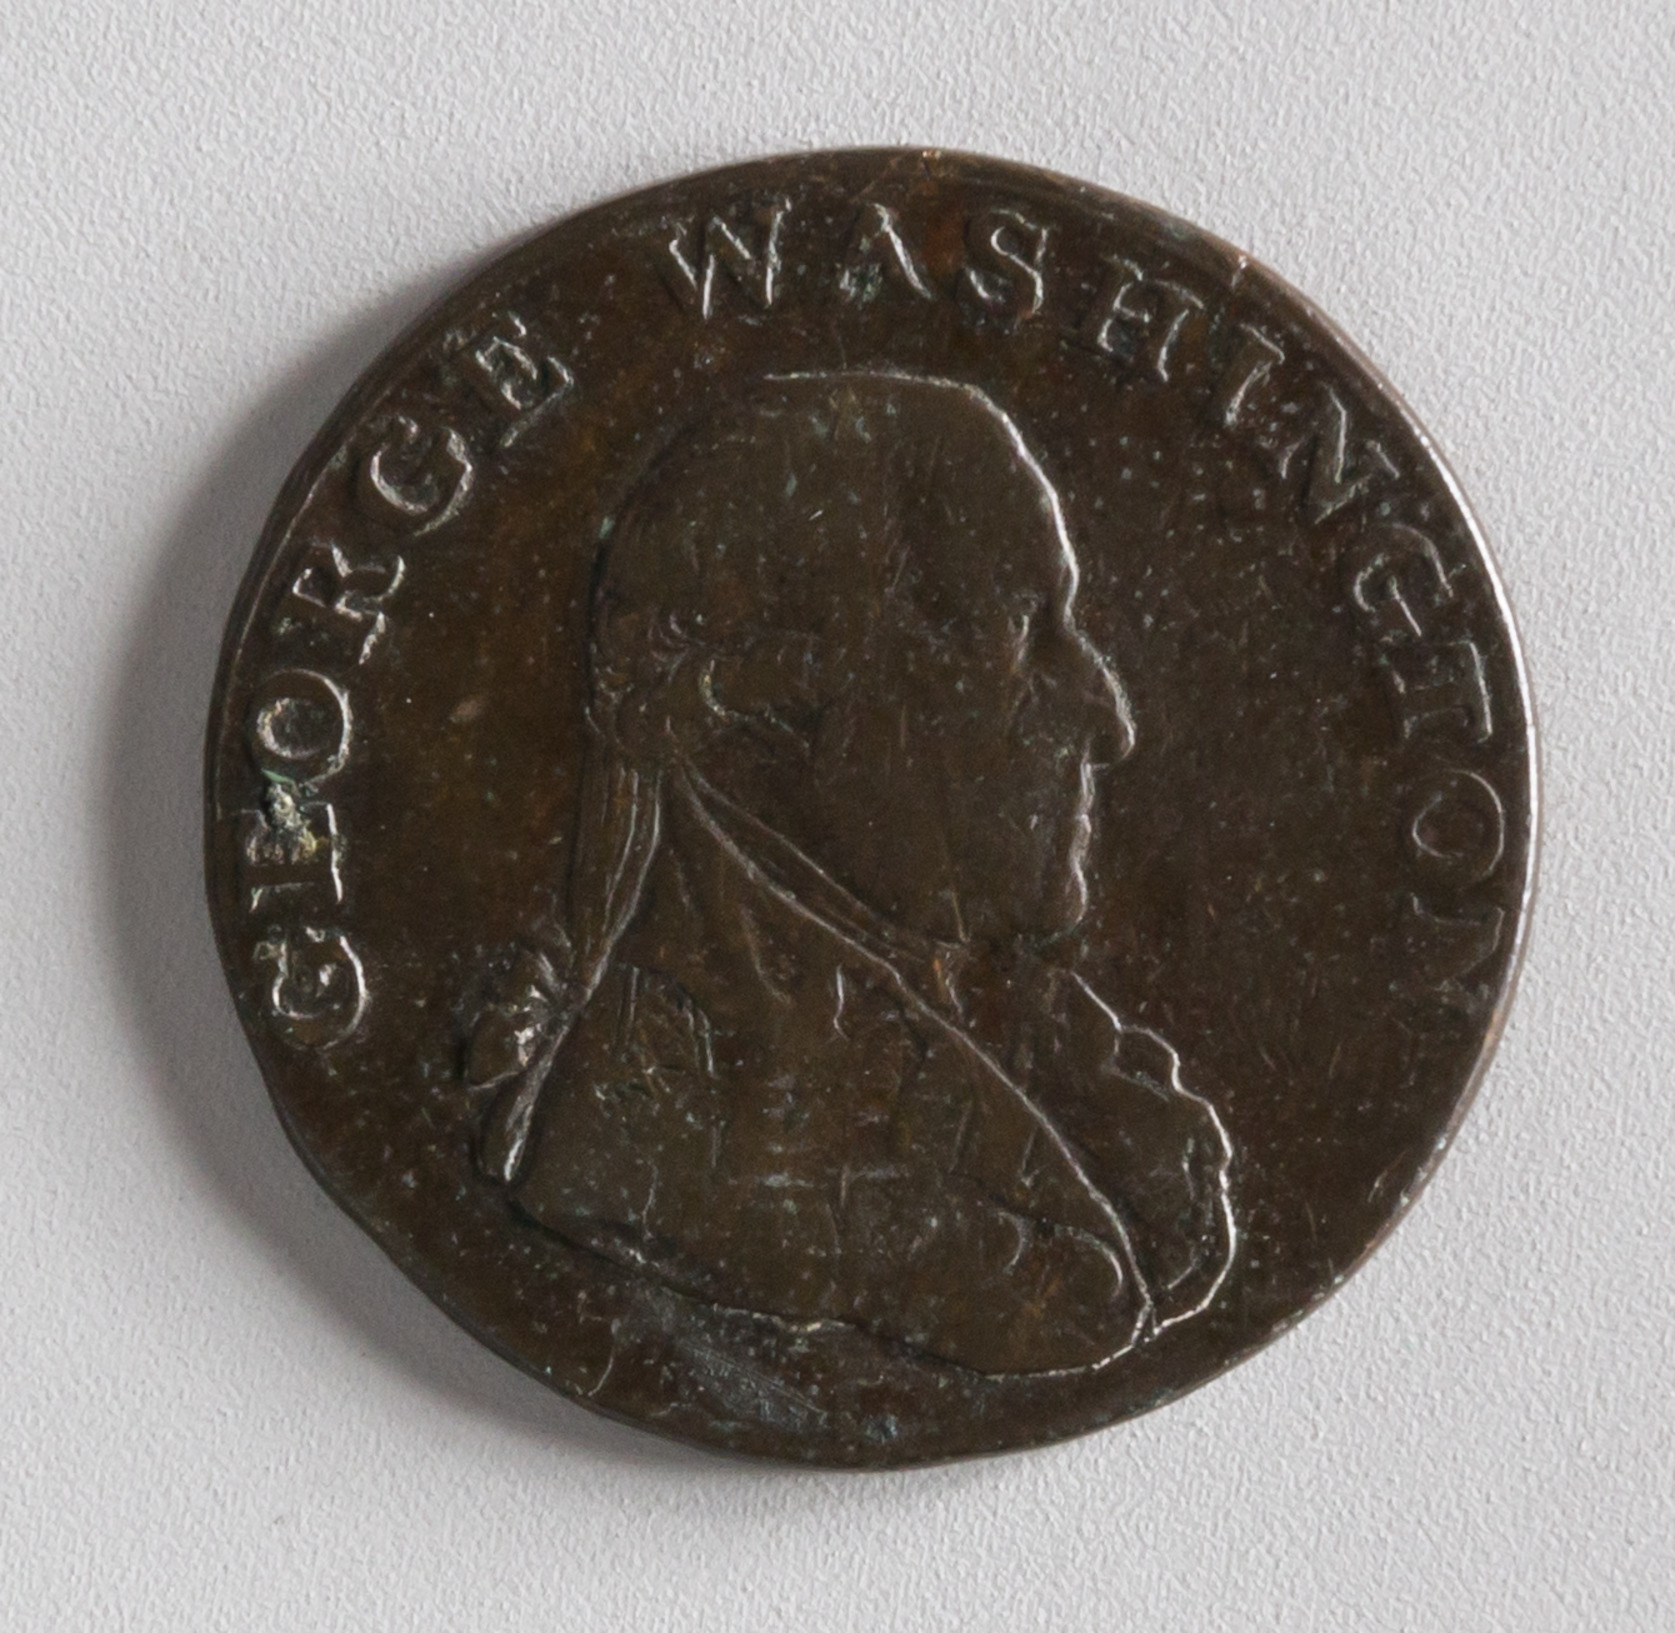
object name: medal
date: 1795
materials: copper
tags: george washington,profiles